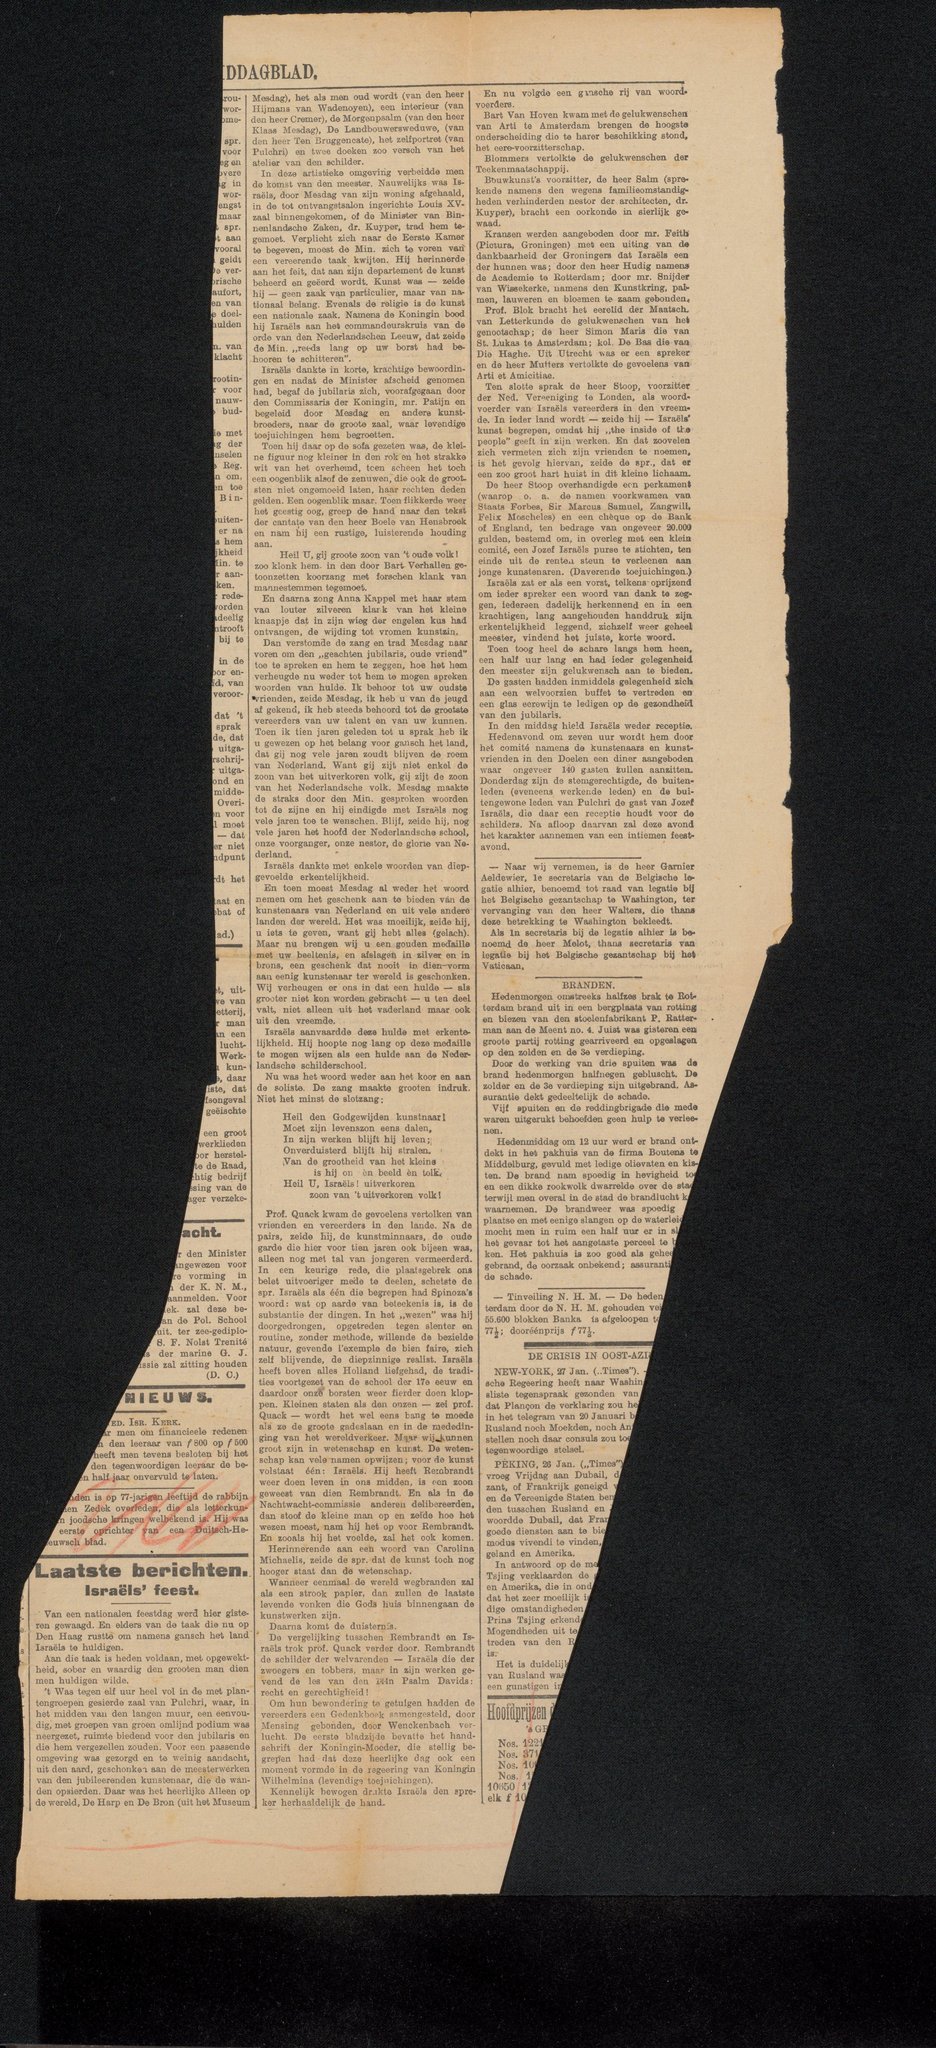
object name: newspaper clipping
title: Krantenknipsel uit archief Philip Zilcken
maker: Anonymous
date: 1904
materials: paper, ink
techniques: printing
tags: print maker, jozef israëls, the hague, painter, draughtsman, philip zilcken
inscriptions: collector's mark: ‘RPK’